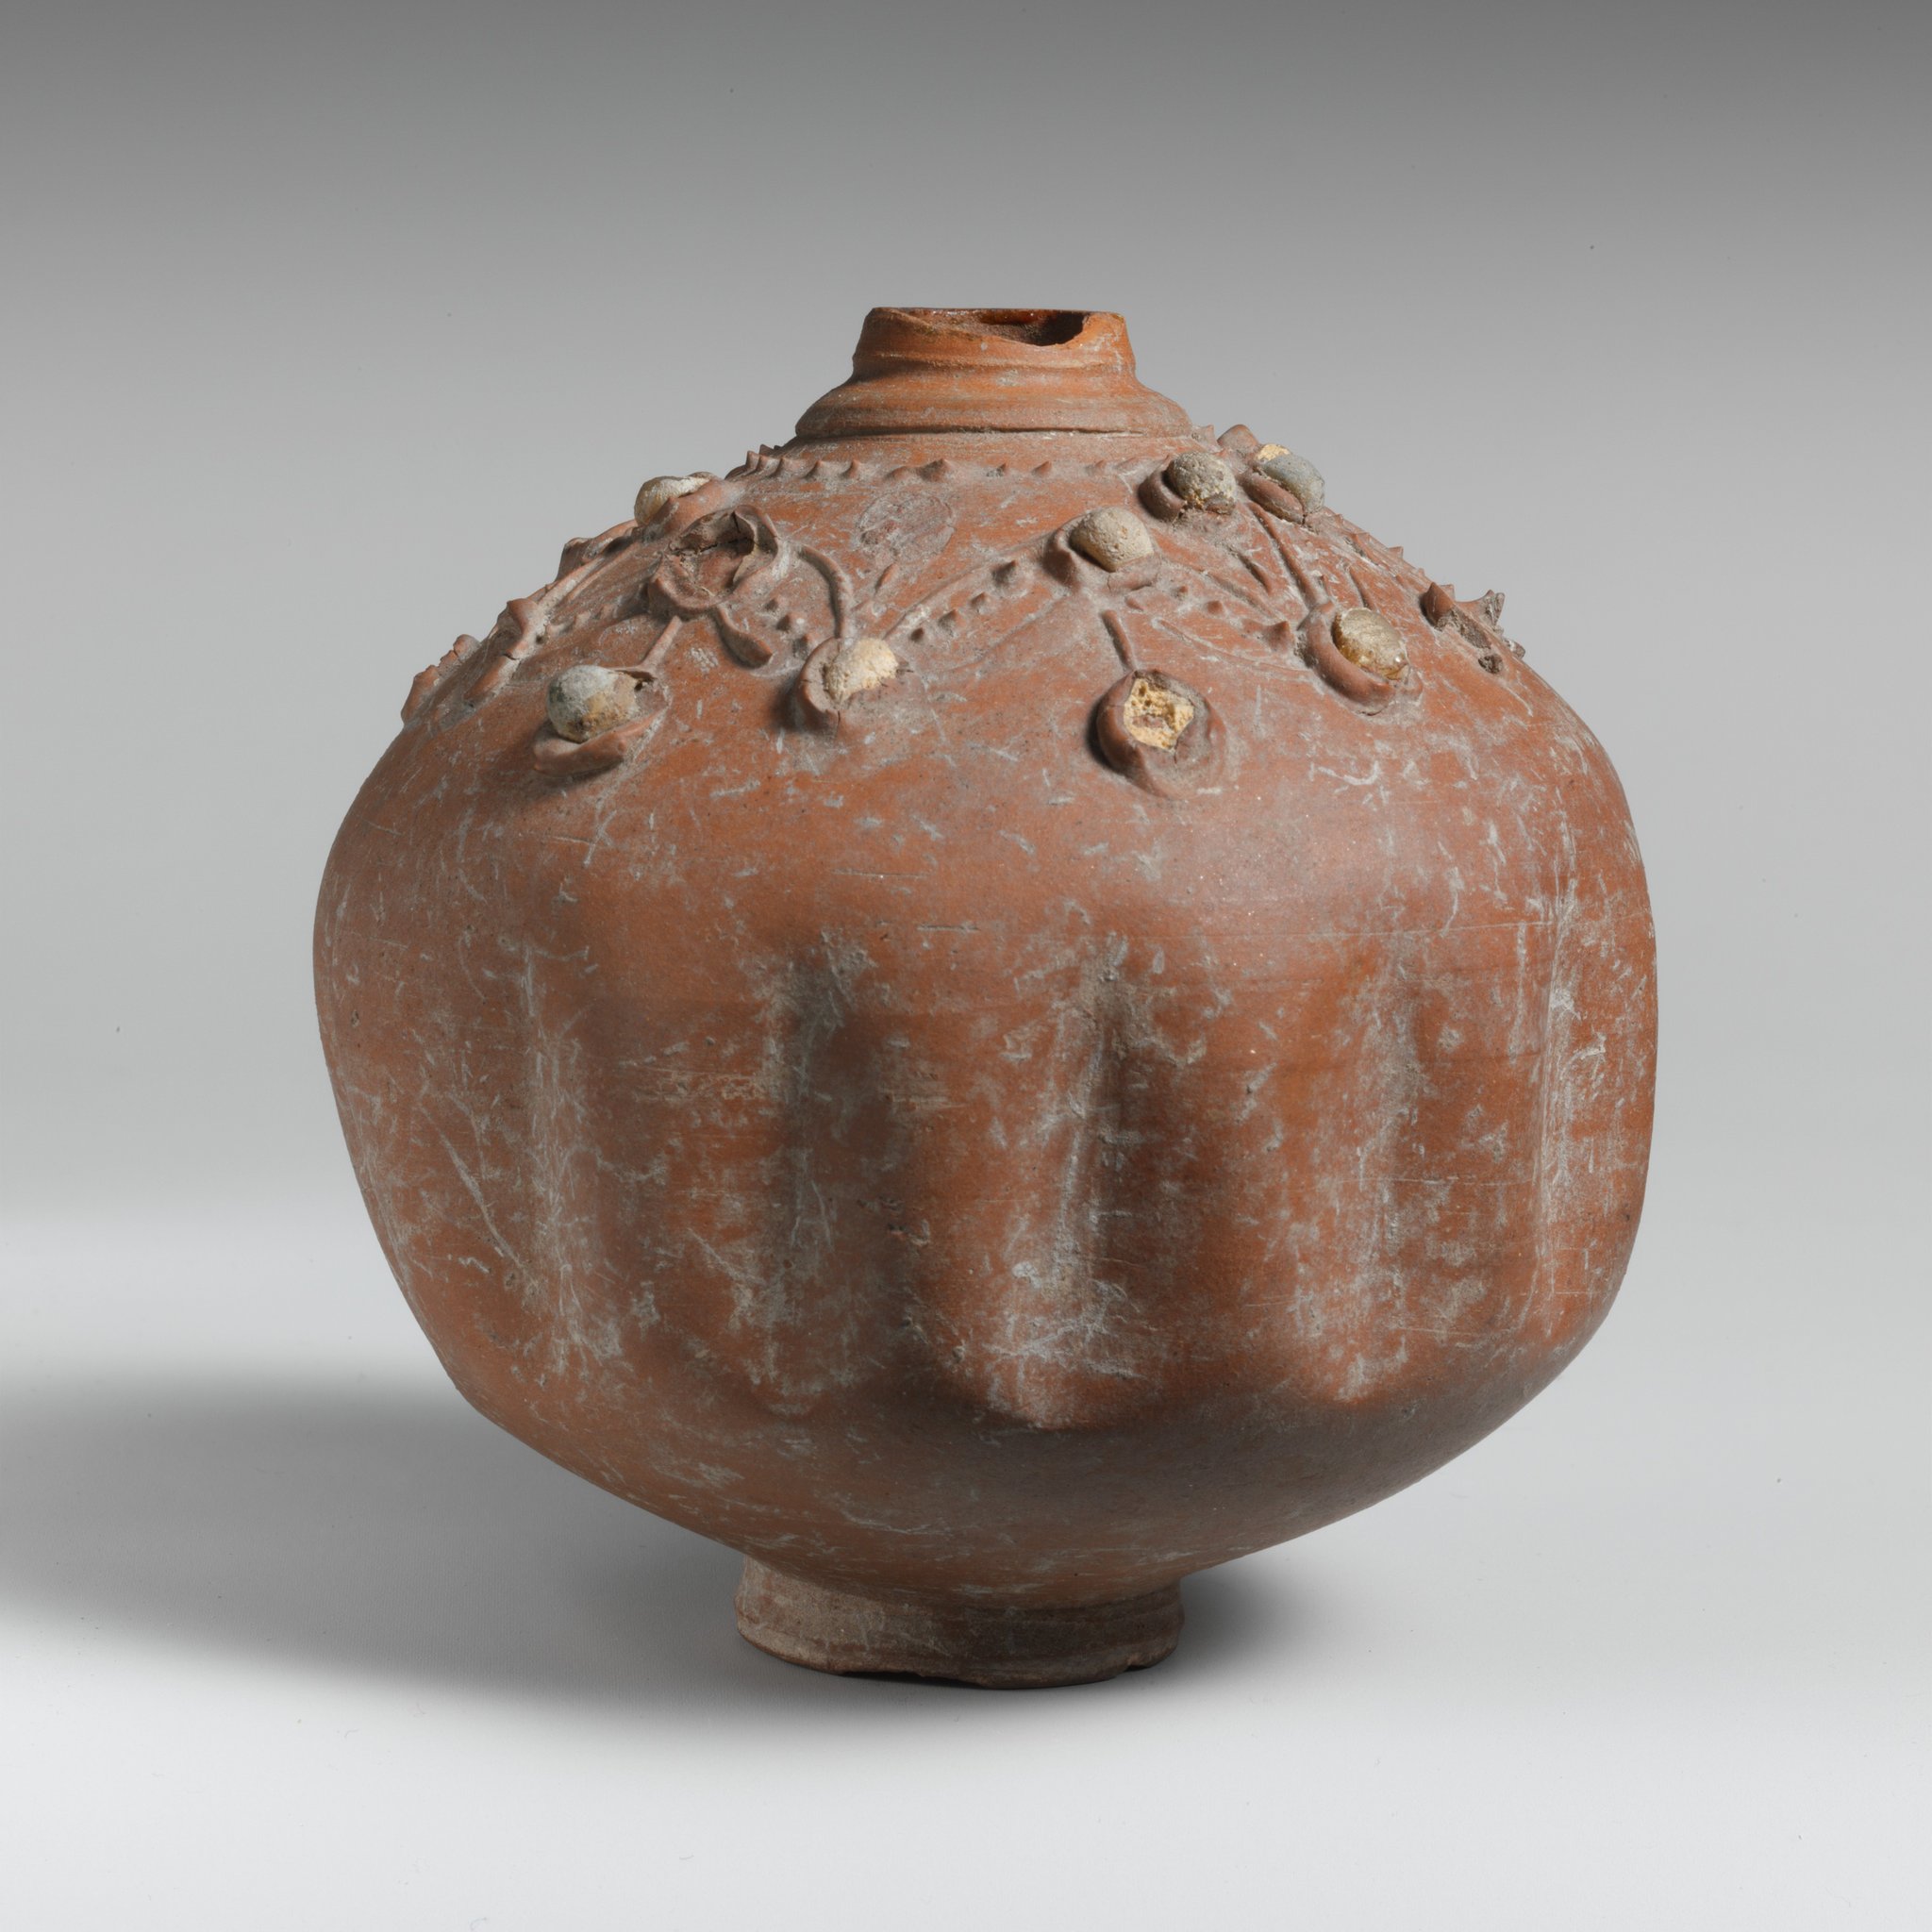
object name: vase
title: Terracotta flask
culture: roman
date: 101-200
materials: terracotta